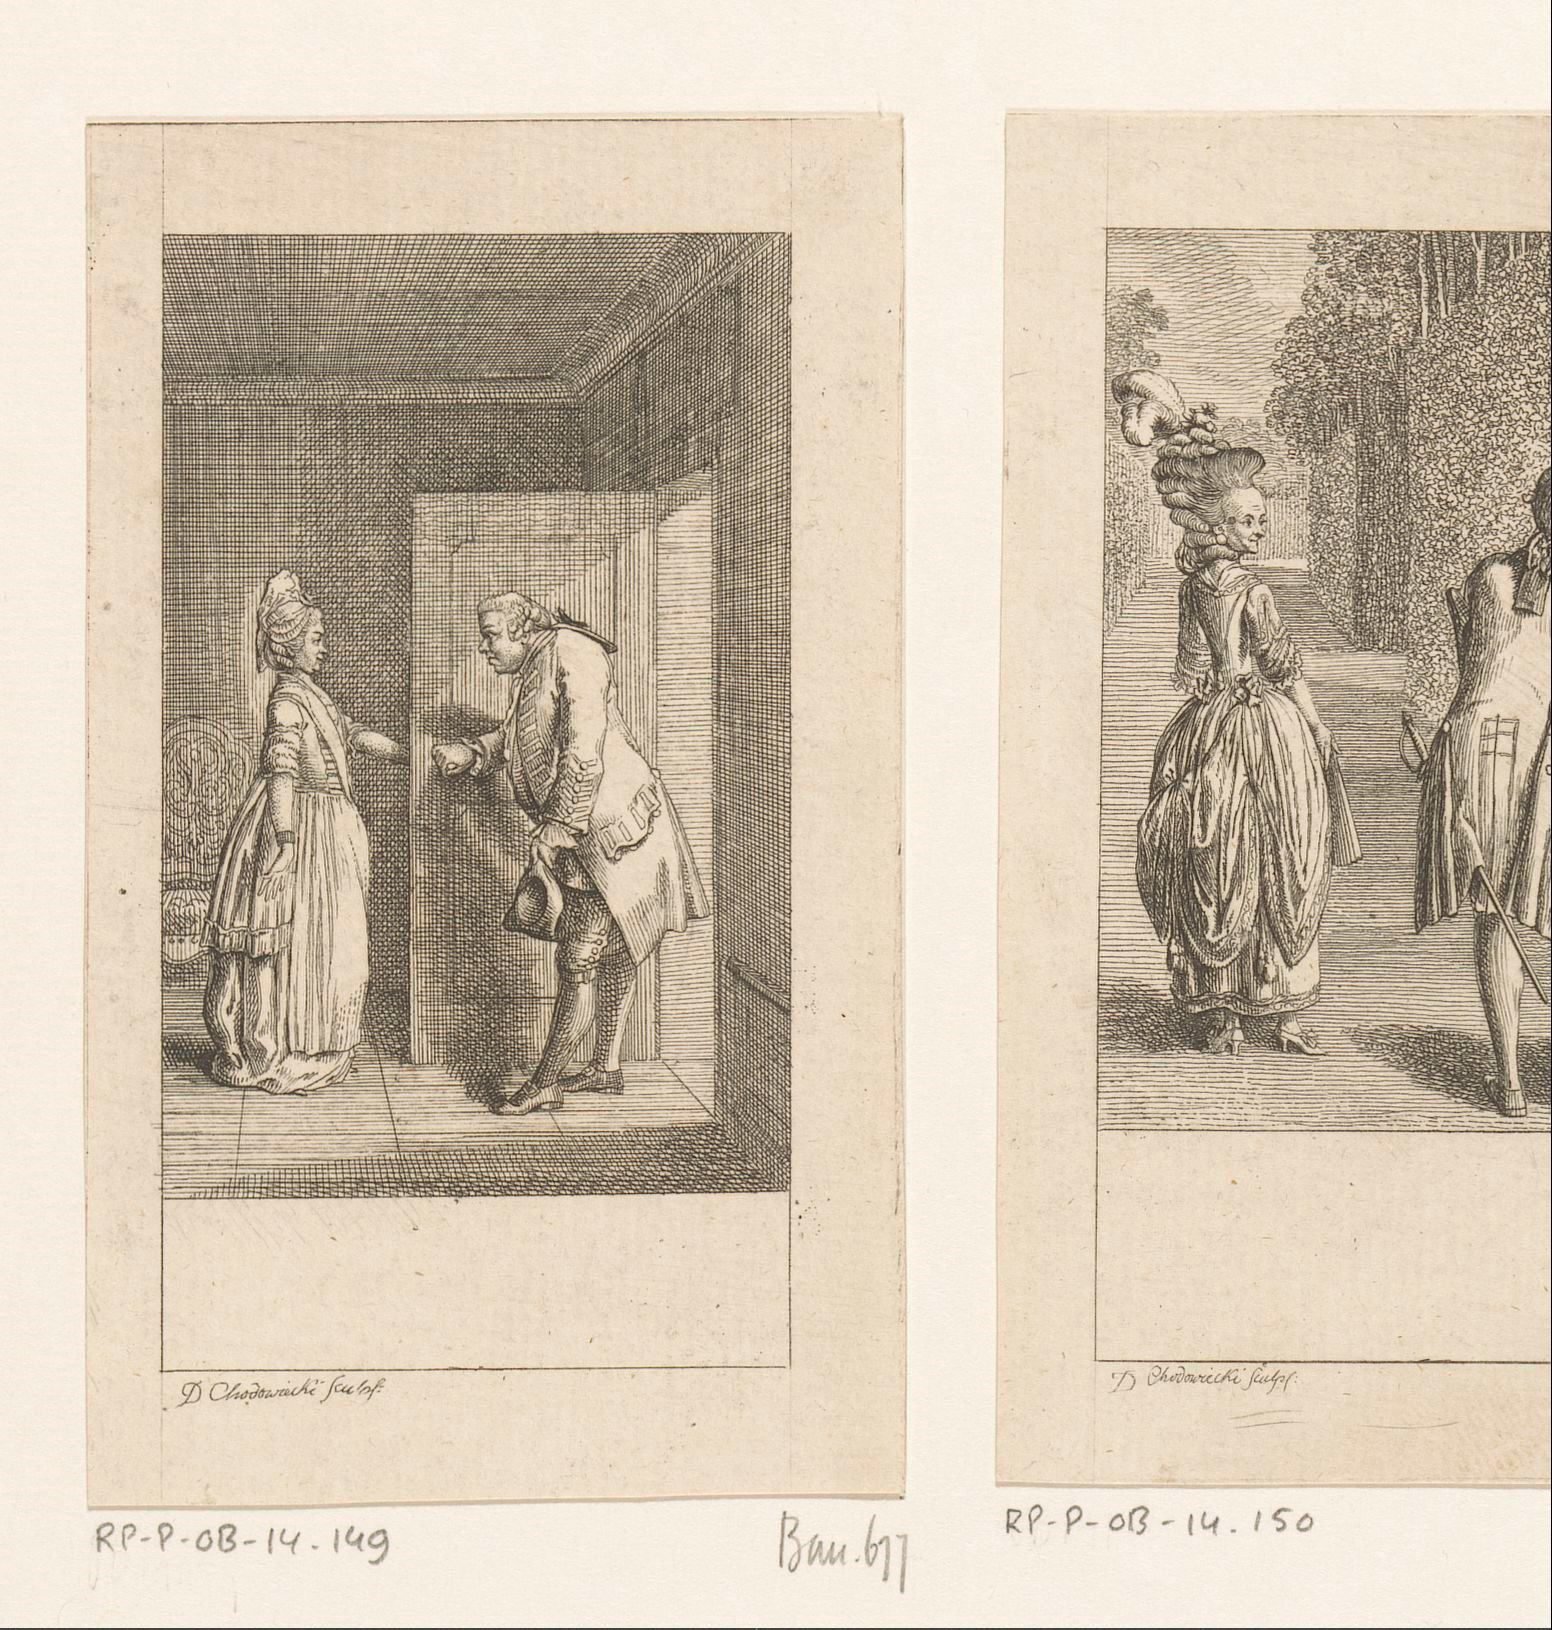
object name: print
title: Vrouw opent de deur voor de buurman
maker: daniel nikolaus chodowiecki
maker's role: draughtsman, print maker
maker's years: 1726-1801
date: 1779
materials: paper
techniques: etching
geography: berlin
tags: open door, literature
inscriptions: collector's mark: Lugt 2228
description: Tweede prent uit een serie van twaalf prenten die de 'Fabeln und Erzählungen' van Gotthold Ephraim Lessing illustreren. De scènes werden op een plaat geëtst. Een latere staat van deze serie is ook gebruikt in: Almanac de Gotha contenant diverses connoissances curieuses et utiles pour l'annee 1780. Gotha, C.W. Ettinger.